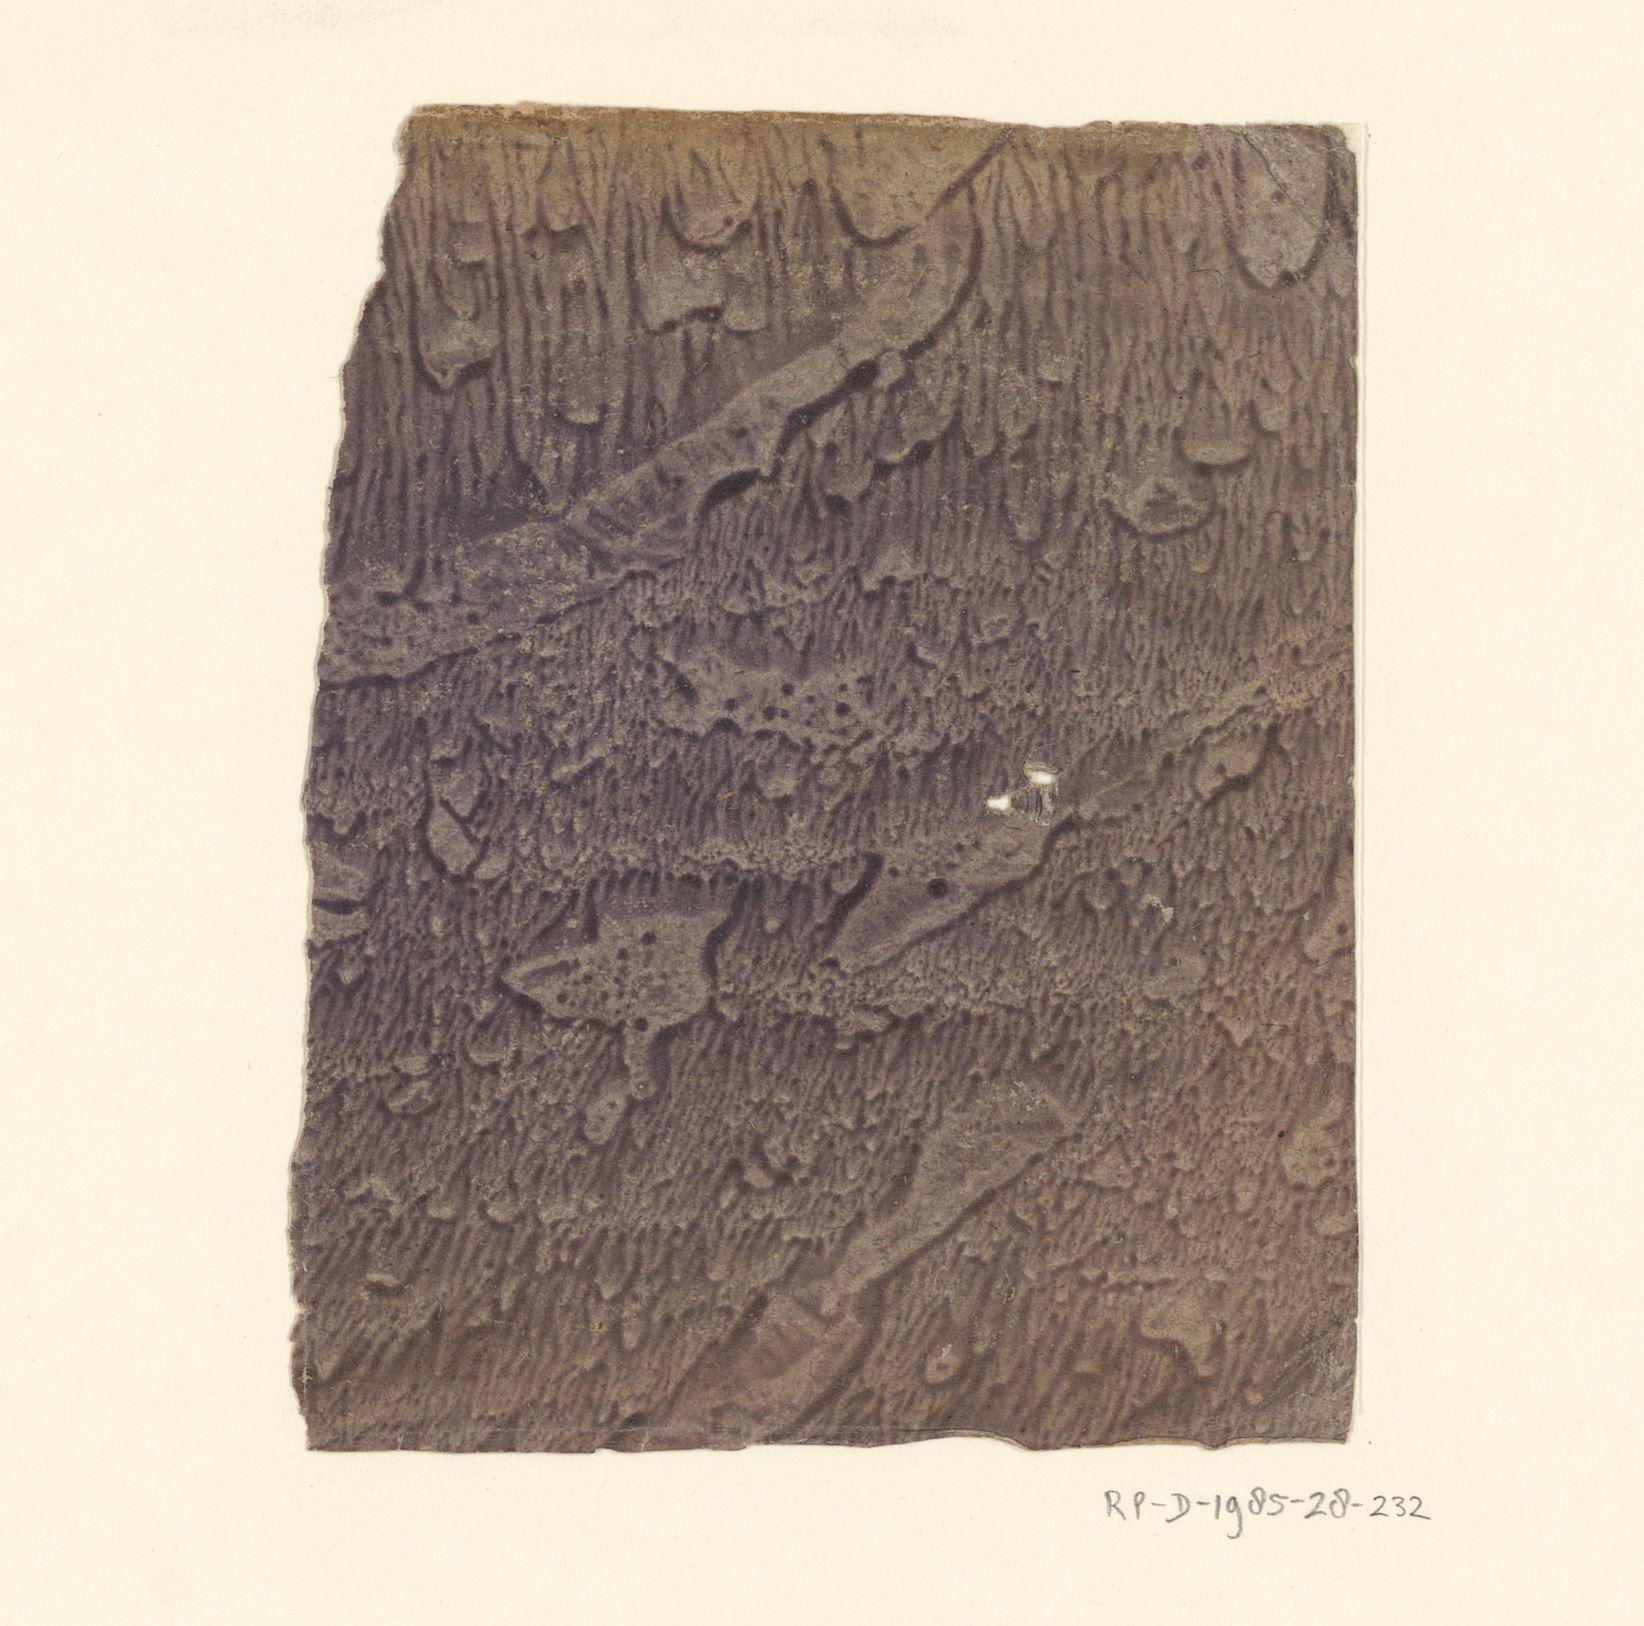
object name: wrapper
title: Losgetrokken stijfselverfpapier in paars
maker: Anonymous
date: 1700-1900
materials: paper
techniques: starch dyeing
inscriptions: collector's mark: Lugt 2760, collector's mark: Lugt 2228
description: Losgetrokken stijfselverfpapier in paars. Op de achterkant is een fragment van een blad uit een botanische publicatie geplakt. Gebruikt als omslag.